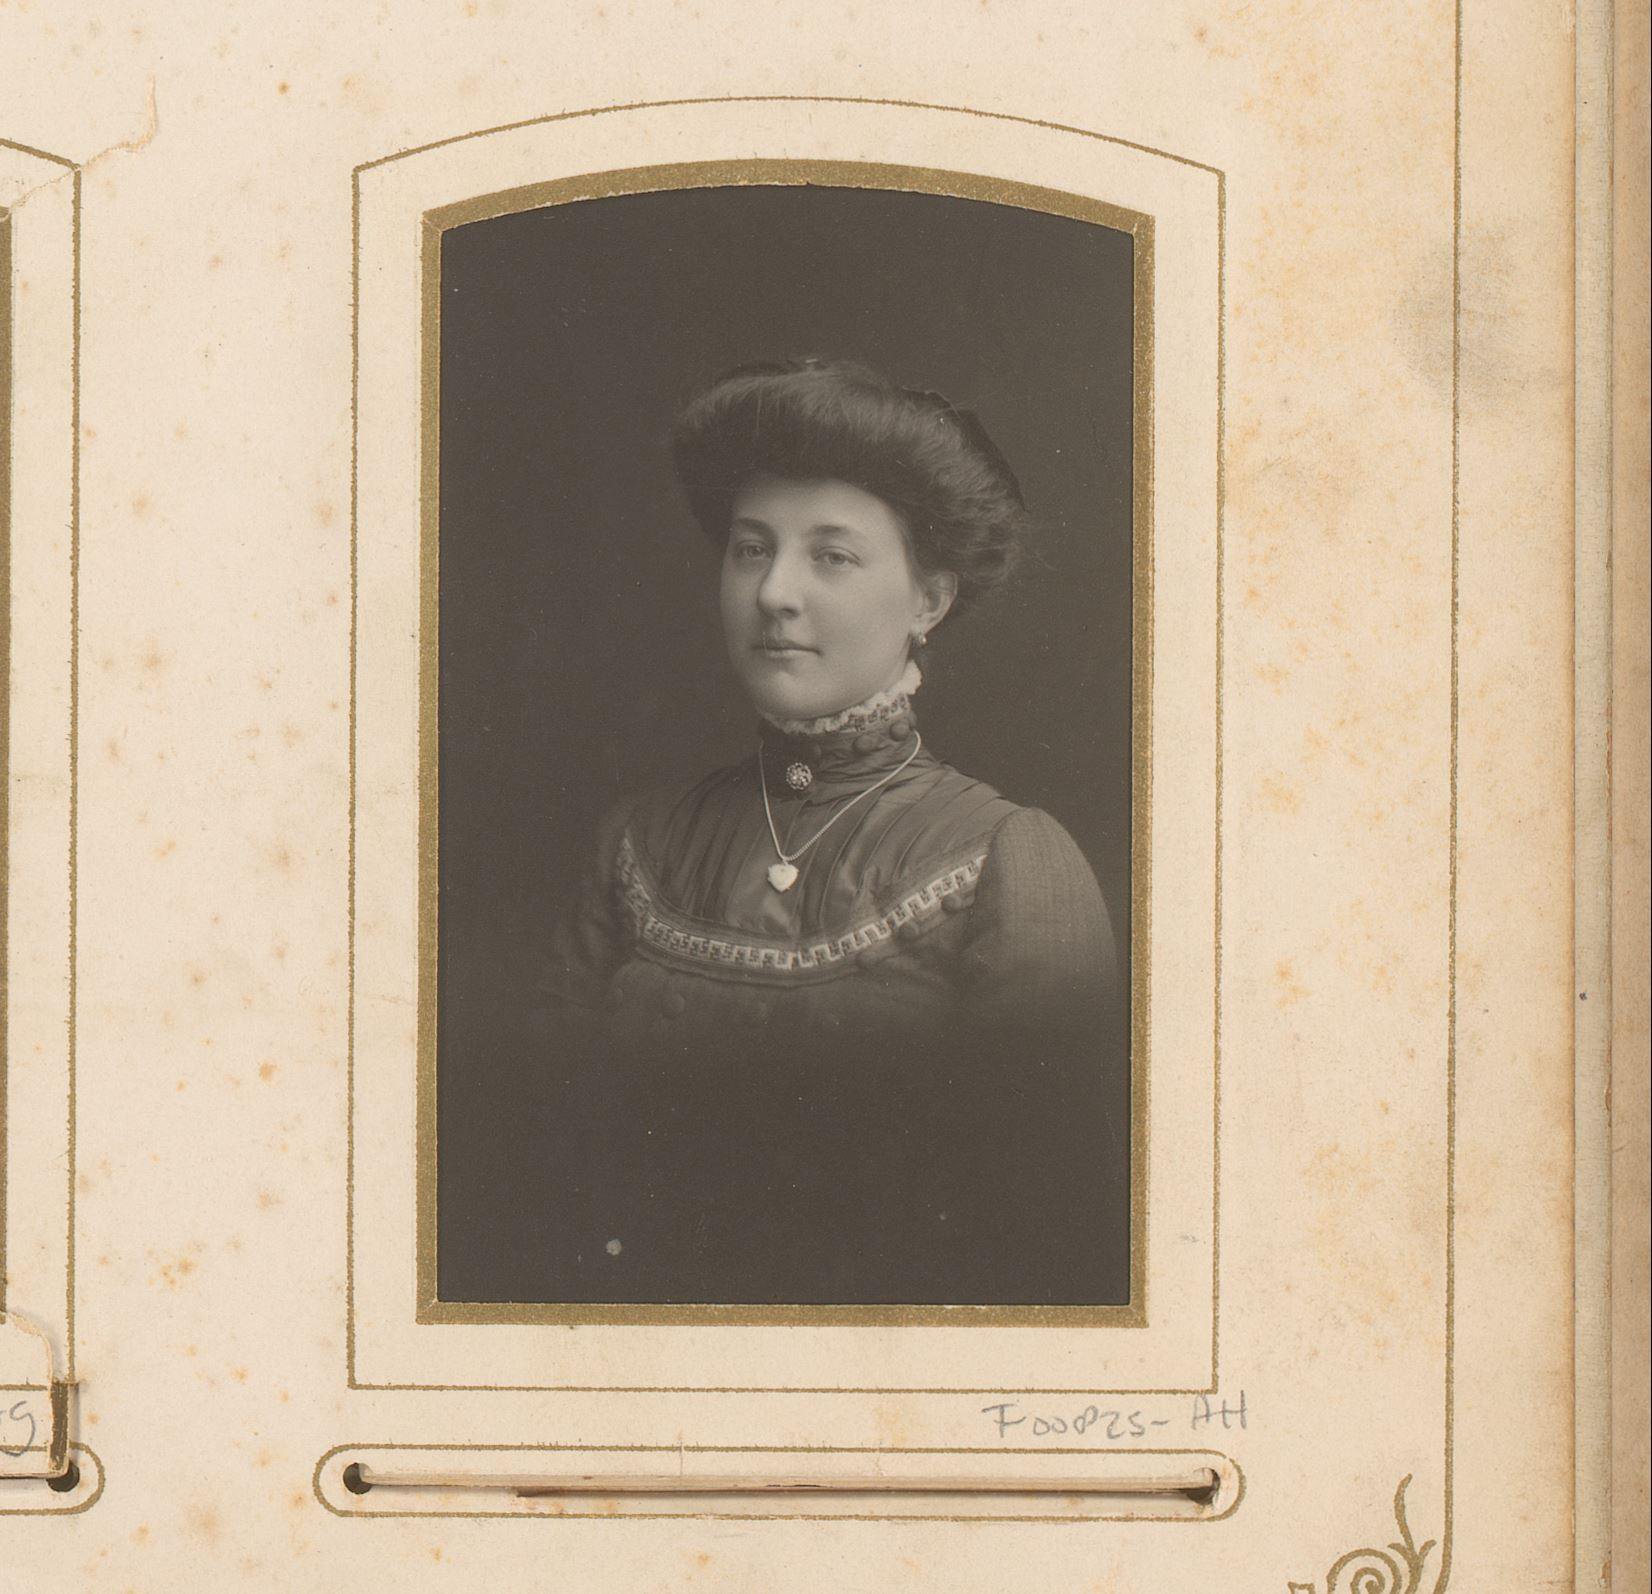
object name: carte de visite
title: Portret van een vrouw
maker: berend zweers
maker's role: fotograaf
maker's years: 1872-1946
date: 1923-1925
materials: cardboard, photographic support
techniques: matte daylight collodion silver print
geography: haarlem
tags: historical persons - bb - woman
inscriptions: inscription: ‘B. Zweers/ GROOTE HOUTSTRAAT 174/ HAARLEM./ Telefoon 1669’